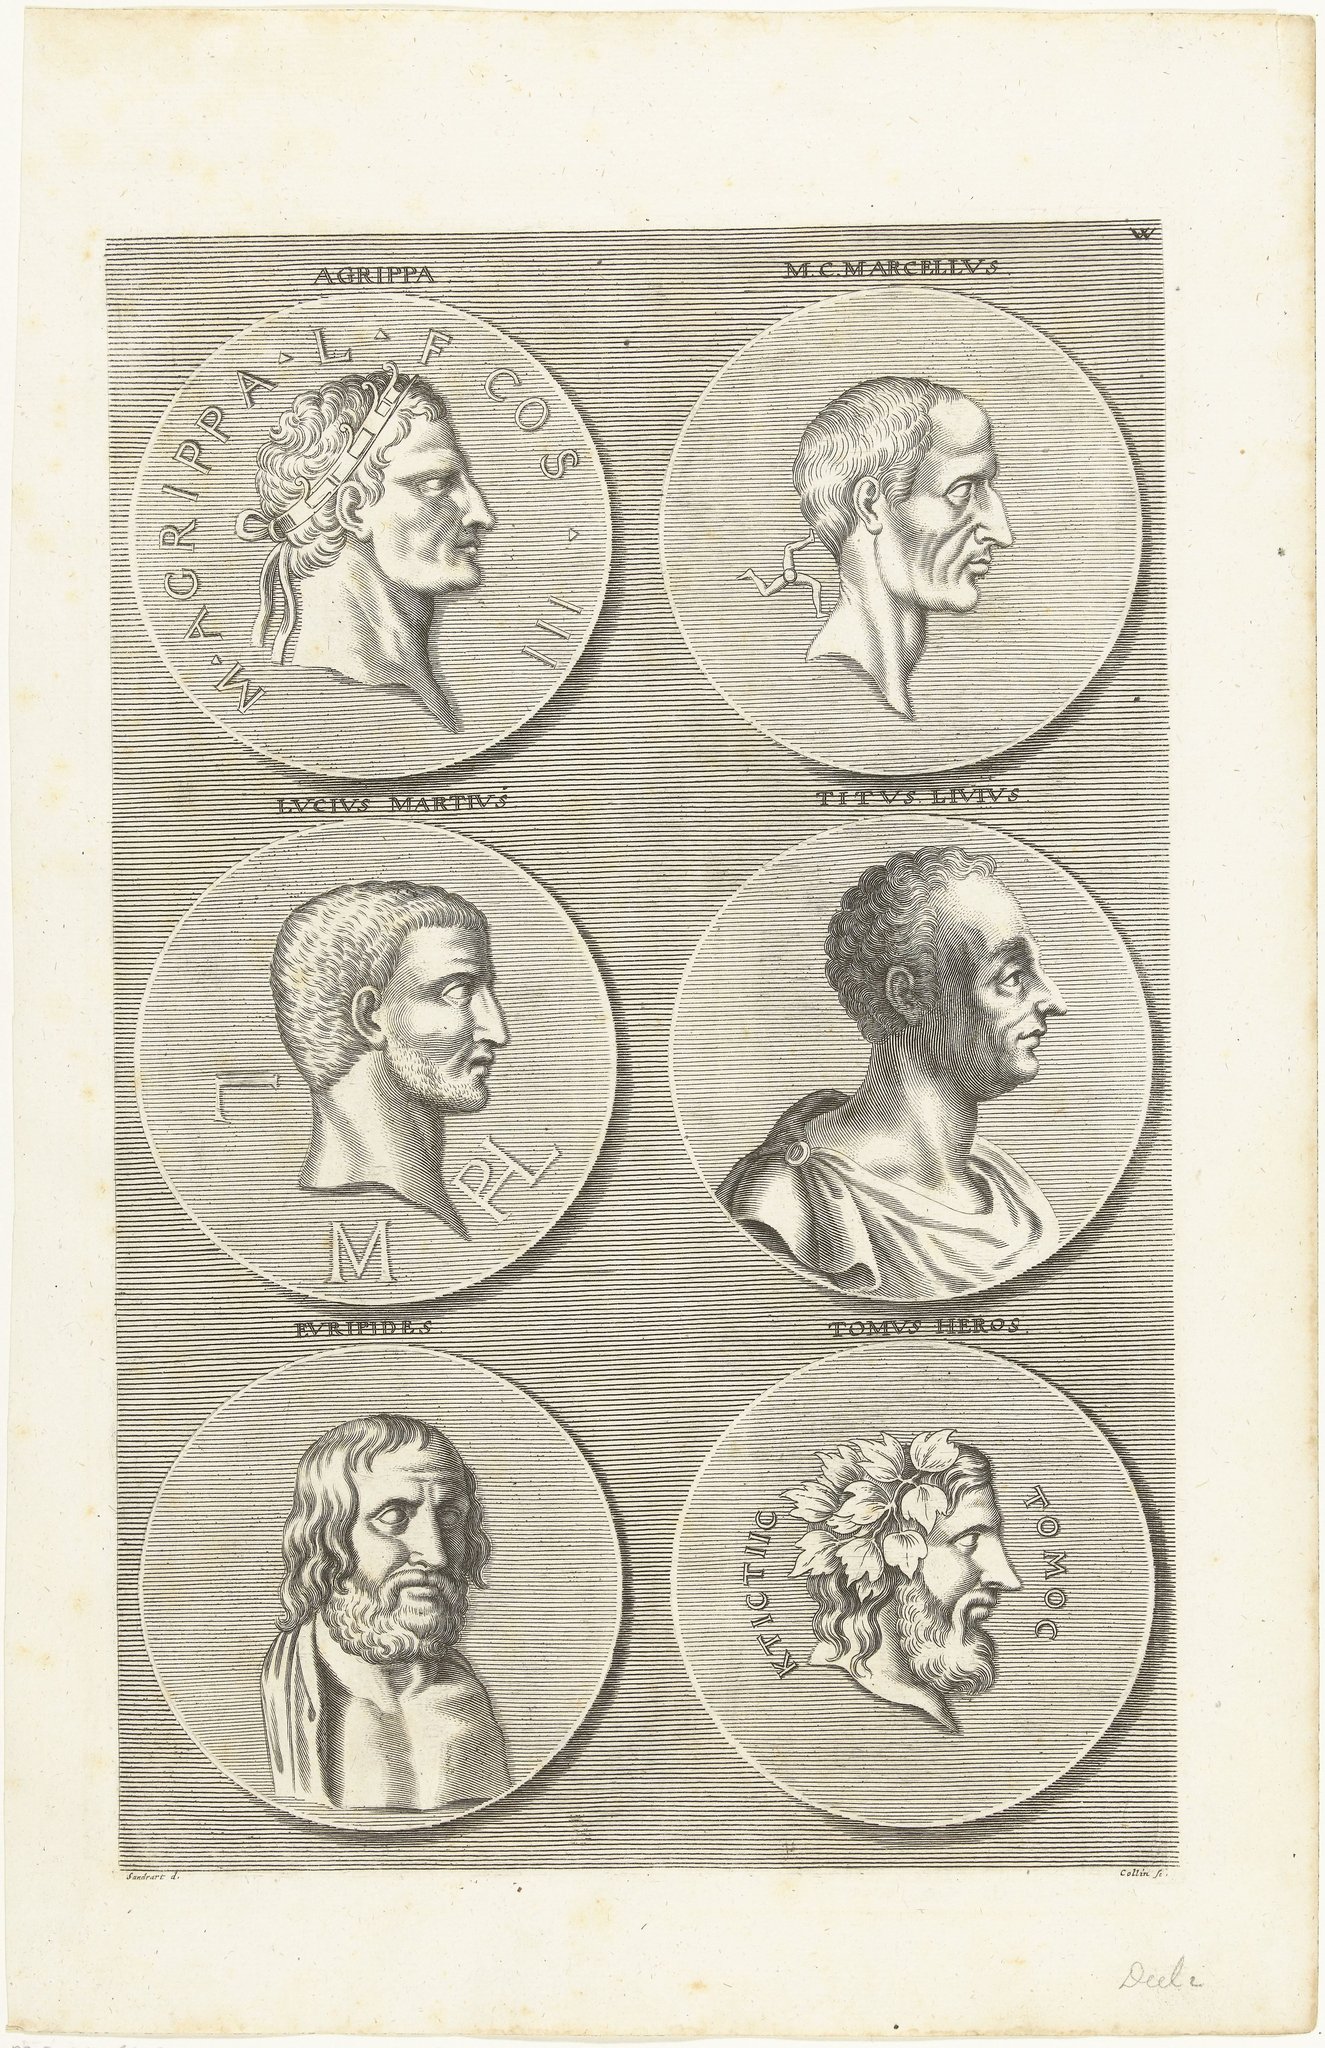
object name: print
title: Zes munten met bekende Romeinen en Grieken: letter W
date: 1675-1680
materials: paper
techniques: engraving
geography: antwerp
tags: coin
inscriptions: collector's mark: Lugt 2228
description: Illustratie voor: Joachim von Sandrart, L'Academia Todesca della Architectura Scultura e Pittura oder Teutsche Academie der Edlen Bau-, Bild- und Mahlerey-Künste. Nürnberg: 1675-1680.